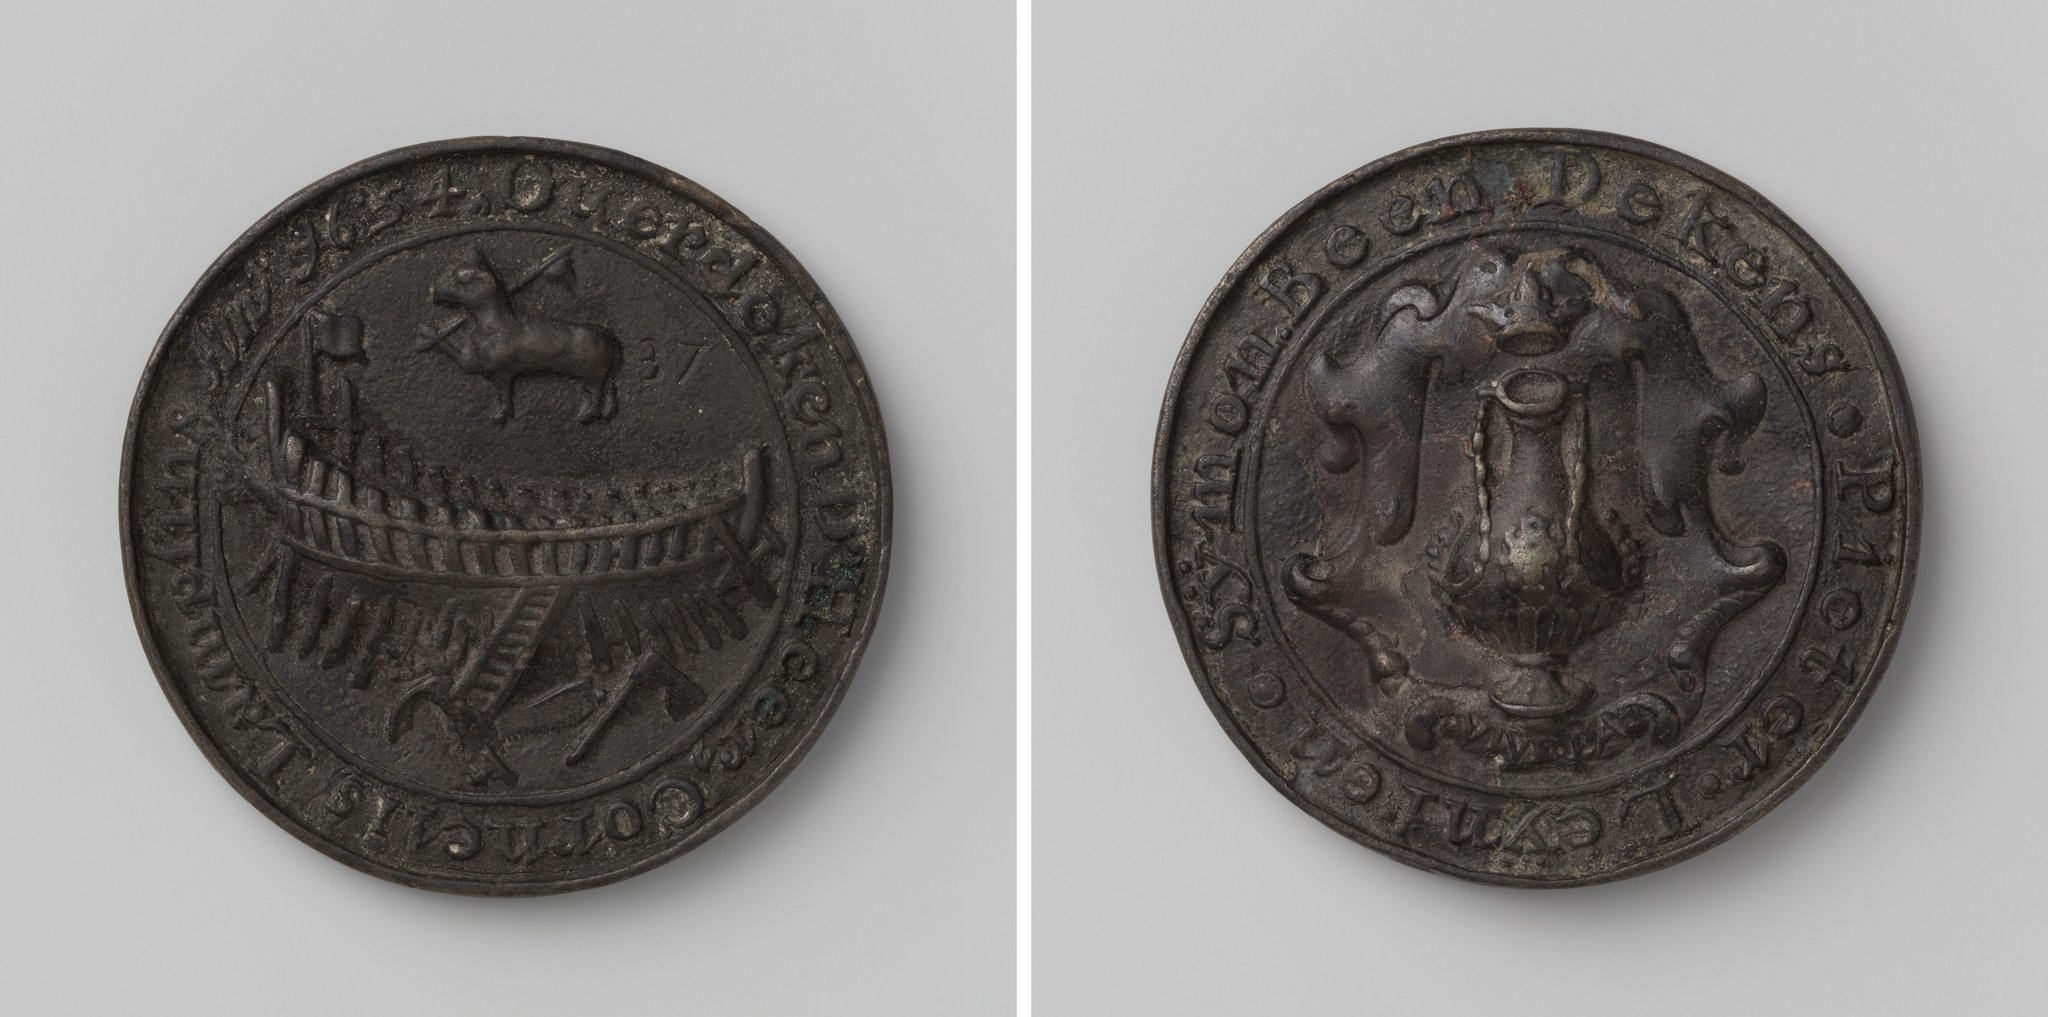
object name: medal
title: Scheepmakersgilde van Vlissingen, gildepenning met no. 37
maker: Anonymous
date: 1654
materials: copper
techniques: casting, engraving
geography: flushing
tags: flushing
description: Koperen penning. Voorzijde: schip in aanbouw met vlag op steven boven zaag tussen twee bijlen; boven schip: lam met vaandel naast cijfer 37 binnen omschrift. Keerzijde: gekroonde fles in cartouche met opschrift op benedenrand binnen omschrift